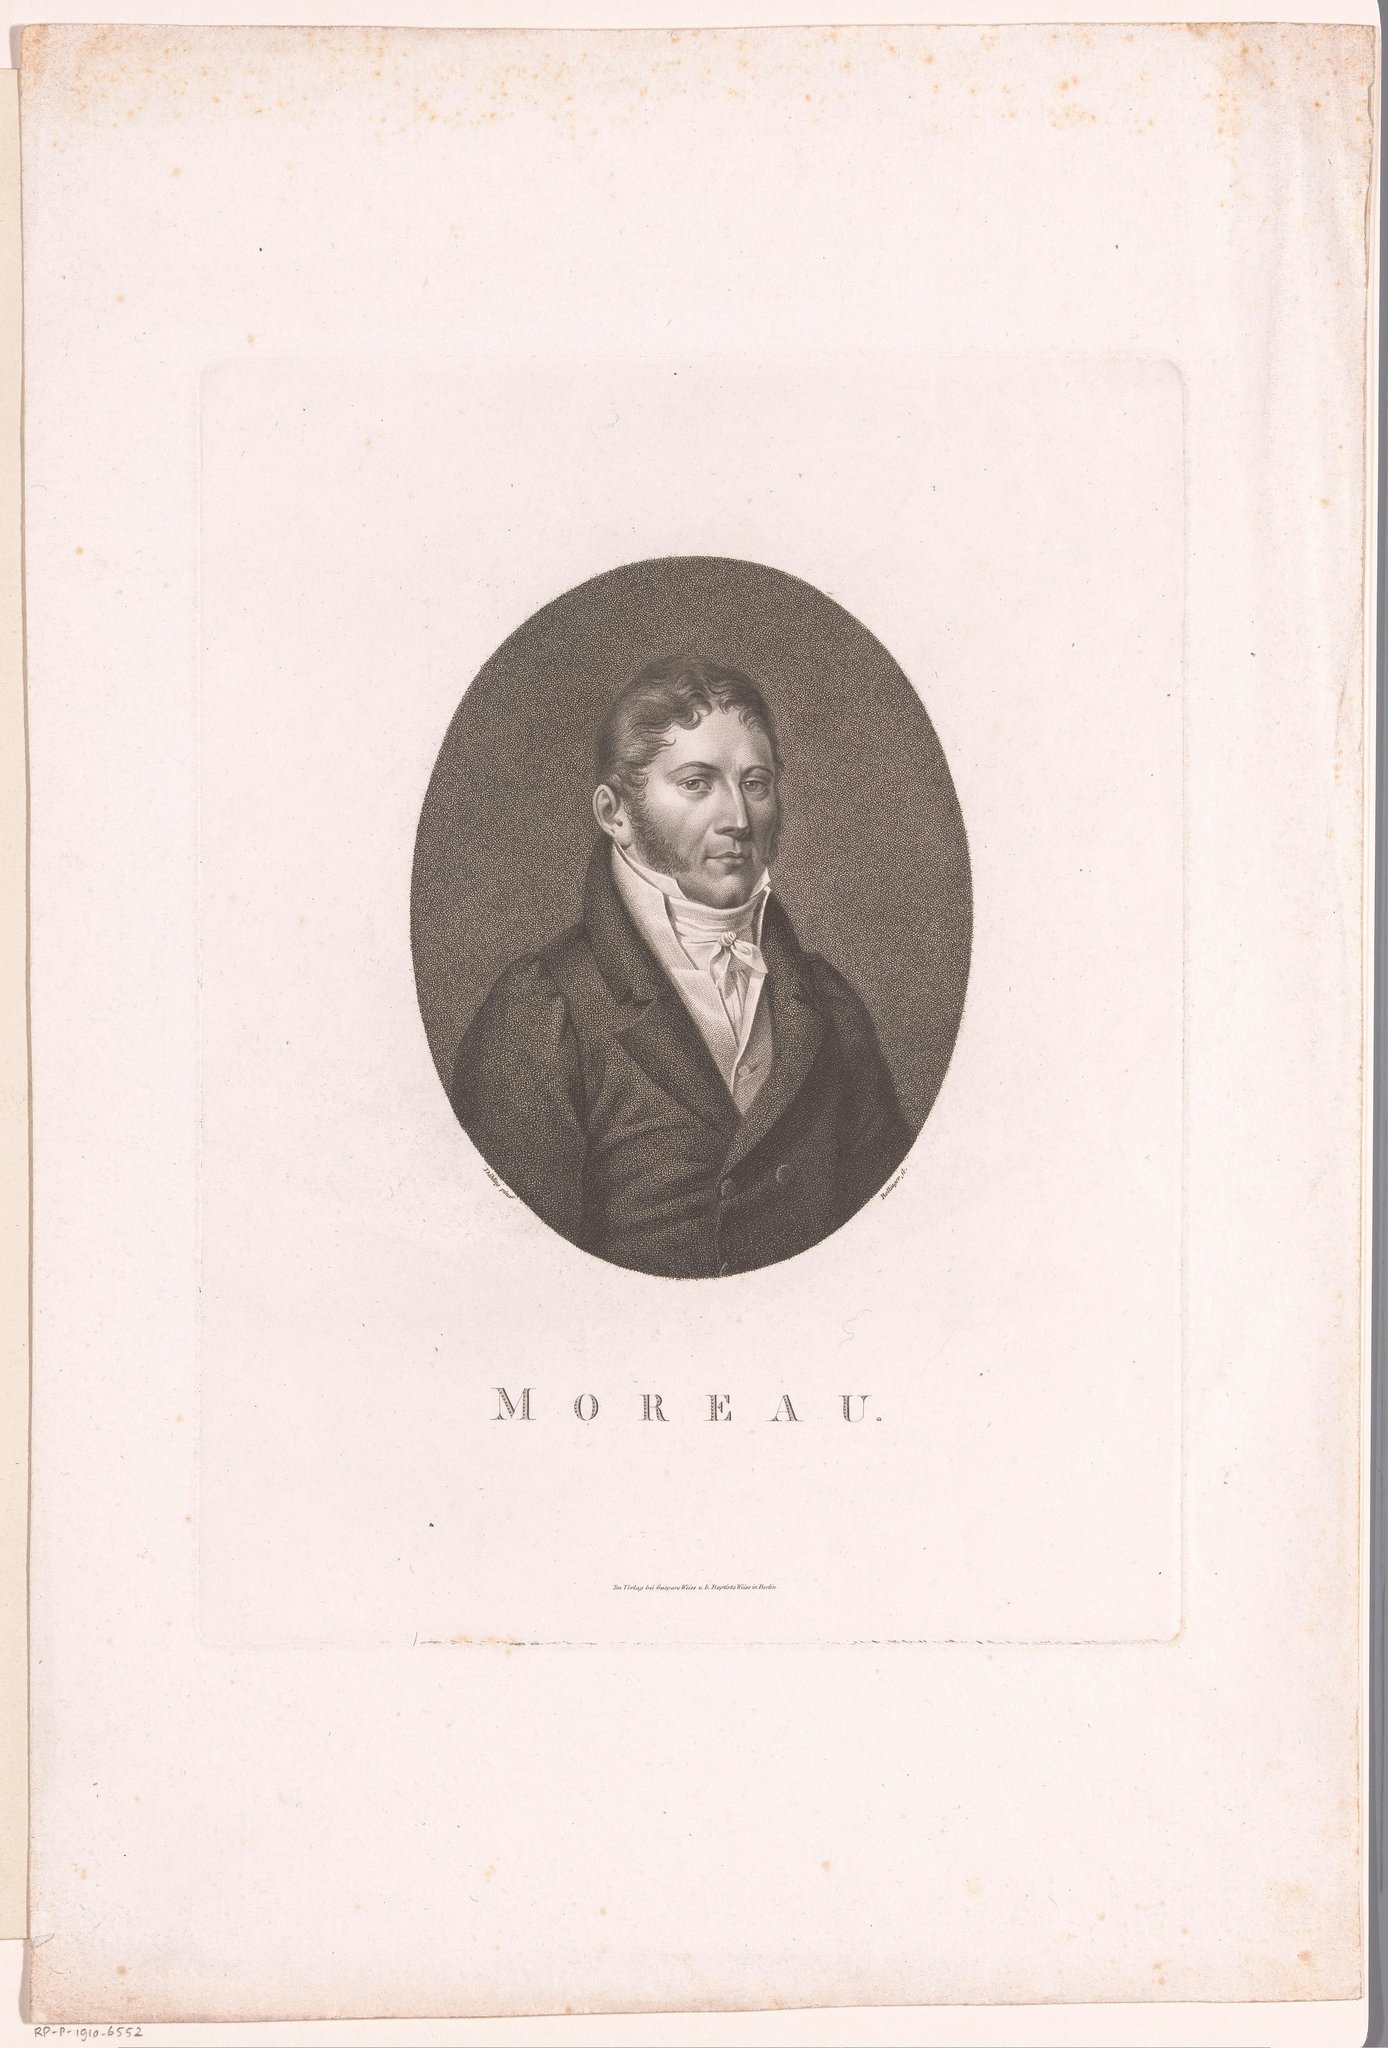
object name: print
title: Portret van Jean Victor Moreau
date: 1800-1825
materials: paper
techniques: stippling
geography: berlin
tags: historical persons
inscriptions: collector's mark: Lugt 2228